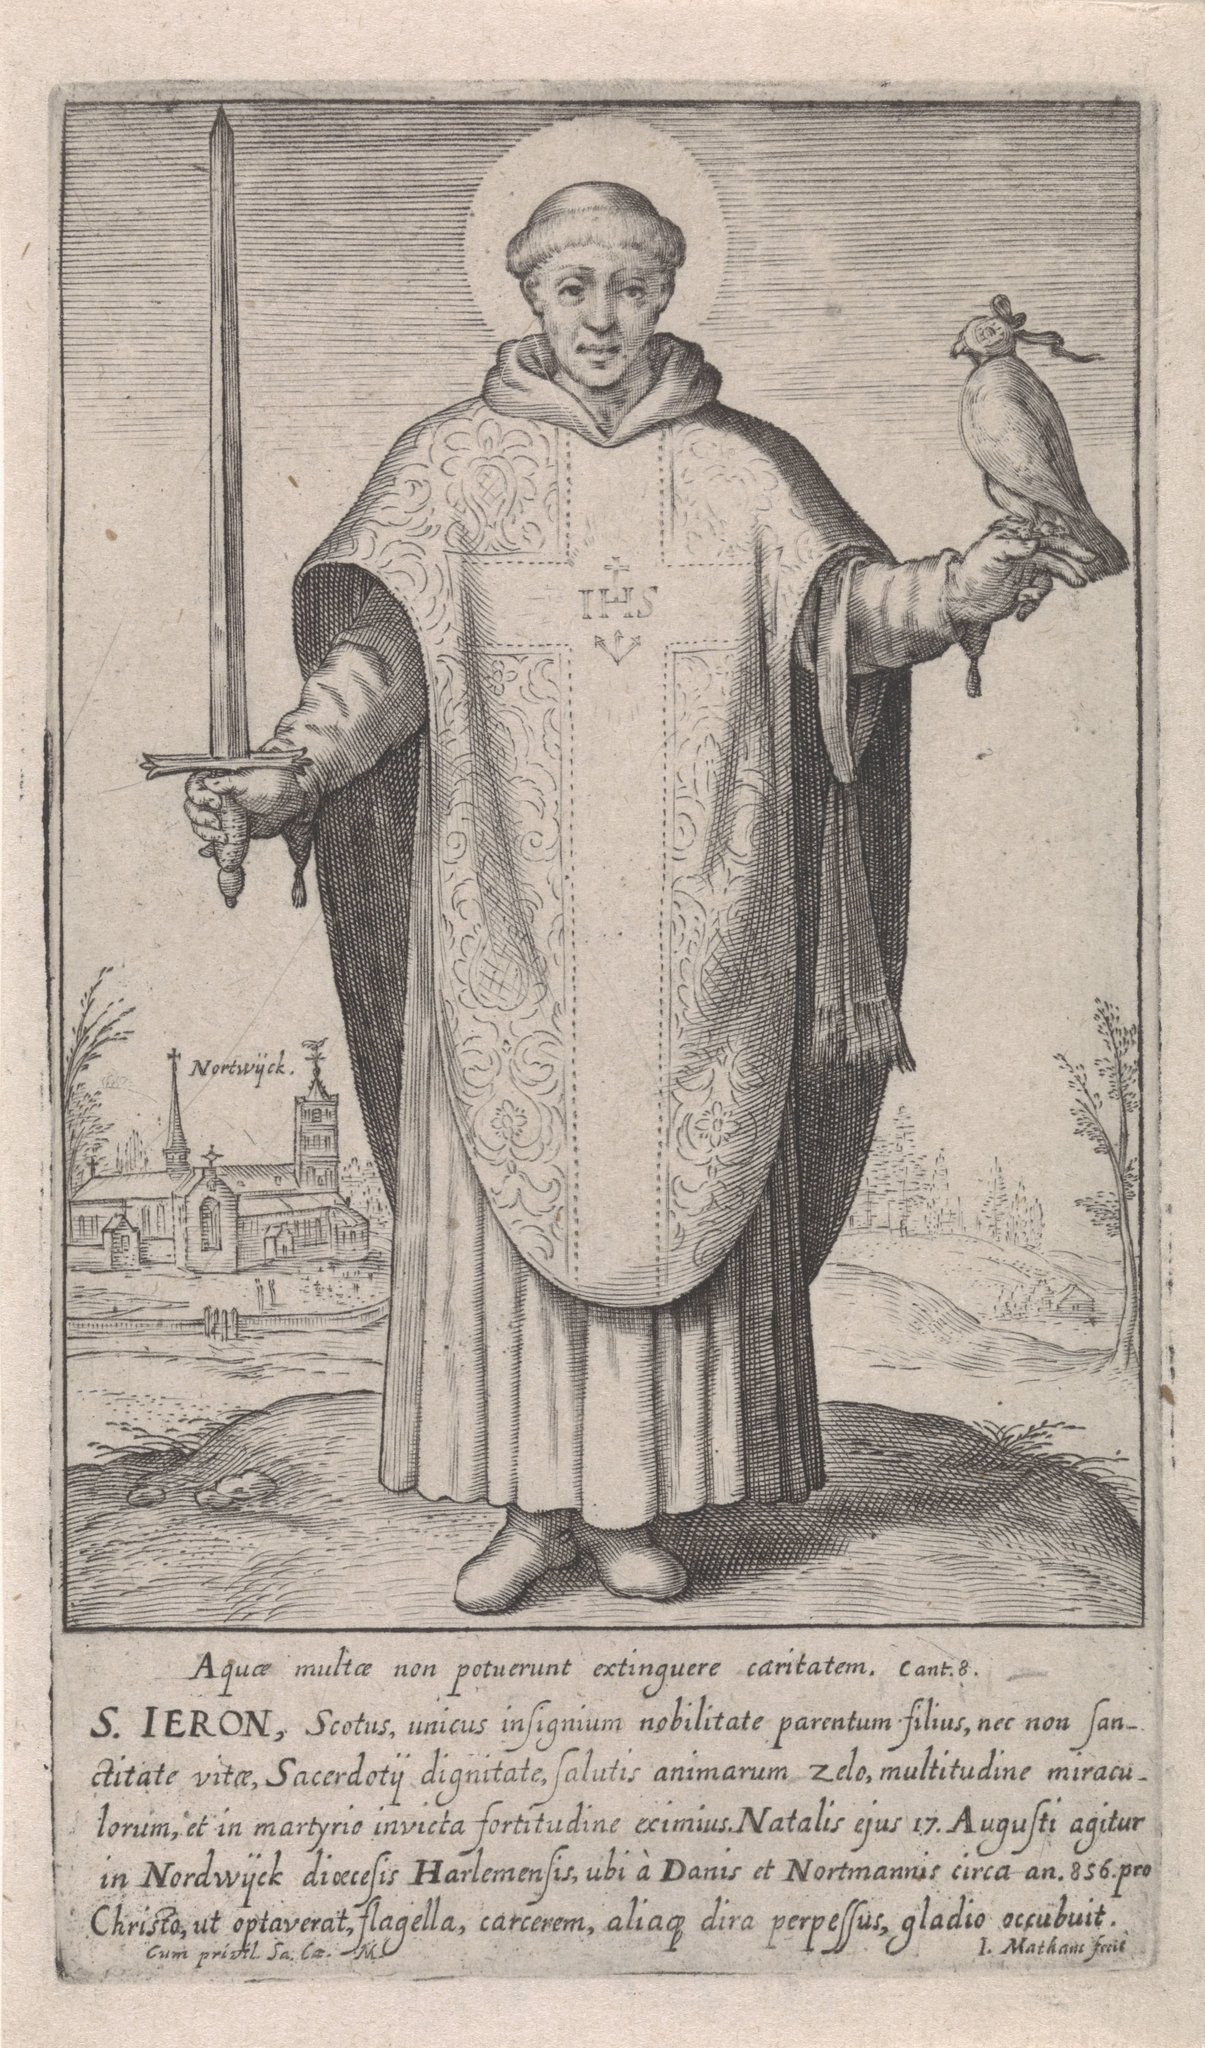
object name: print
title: Heiligen vereerd in Haarlem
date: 1607-1611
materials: paper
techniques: engraving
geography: haarlem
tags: the monk and hermit jerome (hieronymus); possible attributes: book, cardinal's hat, crucifix, hour-glass, lion, skull, stone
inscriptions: signature: ‘J. matham fecit’, collector's mark: Lugt 2228, caption: ‘Aqua multae non poterunt’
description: De heilige Jeroen van Noordwijk met in zijn ene hand een zwaard (hij werd vermoord) en op de andere een valk, welke wijst op zijn adellijke afkomst. Op de achtergrond de kerk van Noordwijk die hij bouwde. Prent uit een serie van vijf prenten met heiligen die vereerd worden in Haarlem.